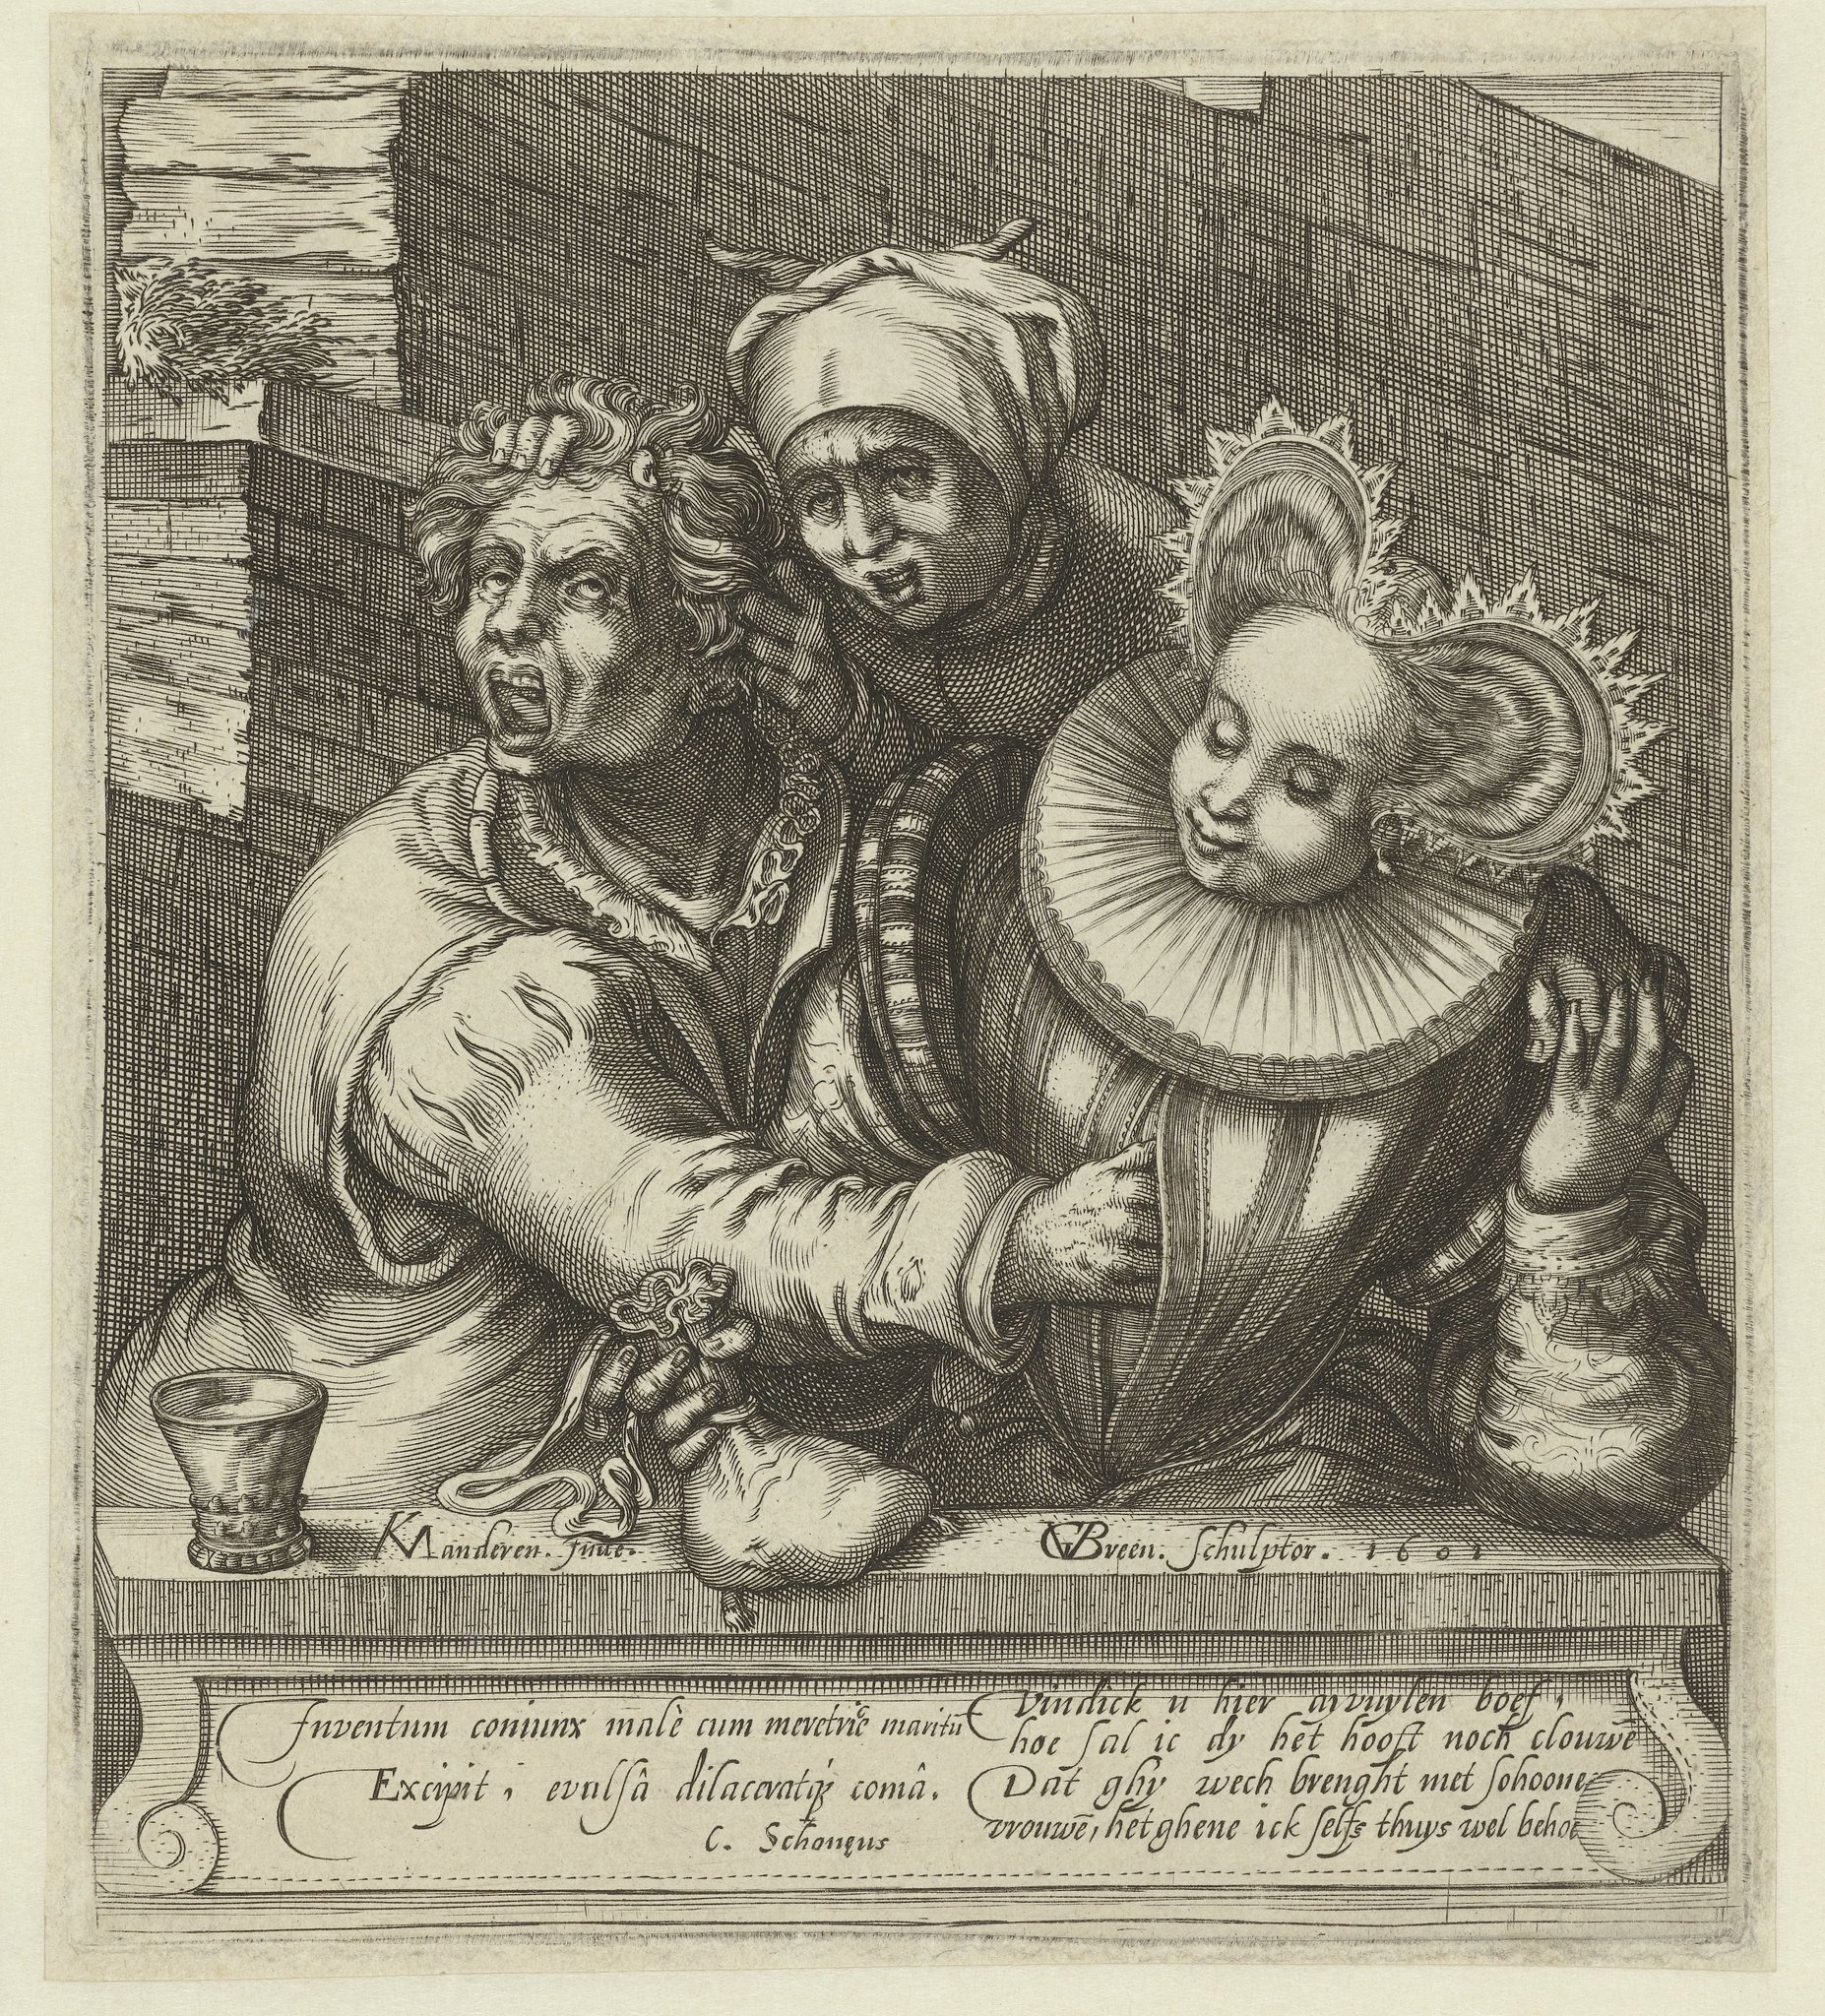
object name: print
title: De betrapte echtgenoot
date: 1601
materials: paper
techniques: engraving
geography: haarlem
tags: head-gear (with name), head-gear: cap (+ women's clothes), neck-gear ~ clothing (with name) (+ women's clothes), whore, prostitute, neck-gear: collar (+ men's clothes), clothing for the upper part of the body (doublet) (+ men's clothes), gripping someone by the hair, satire on marriage, clothing for the upper part of the body (with name) (+ women's clothes), purse, money-bag (+ women's clothes)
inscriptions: collector's mark: Lugt 2228, caption: ‘Vind ick u hier ay vuylen boef ...’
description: Een man die zijn geld er doorjaagt bij een jonge vrouw, wordt door zijn echtgenote verrast en aan de haren getrokken. De jonge vrouw houdt de beurs van de man in haar handen. Onder de voorstelling een Latijns vers van Cornelius Schonaeus en in het Nederlands de verwensingen die de echtgenote haar man toeroept: Vindick u hier ay vuylen boef...